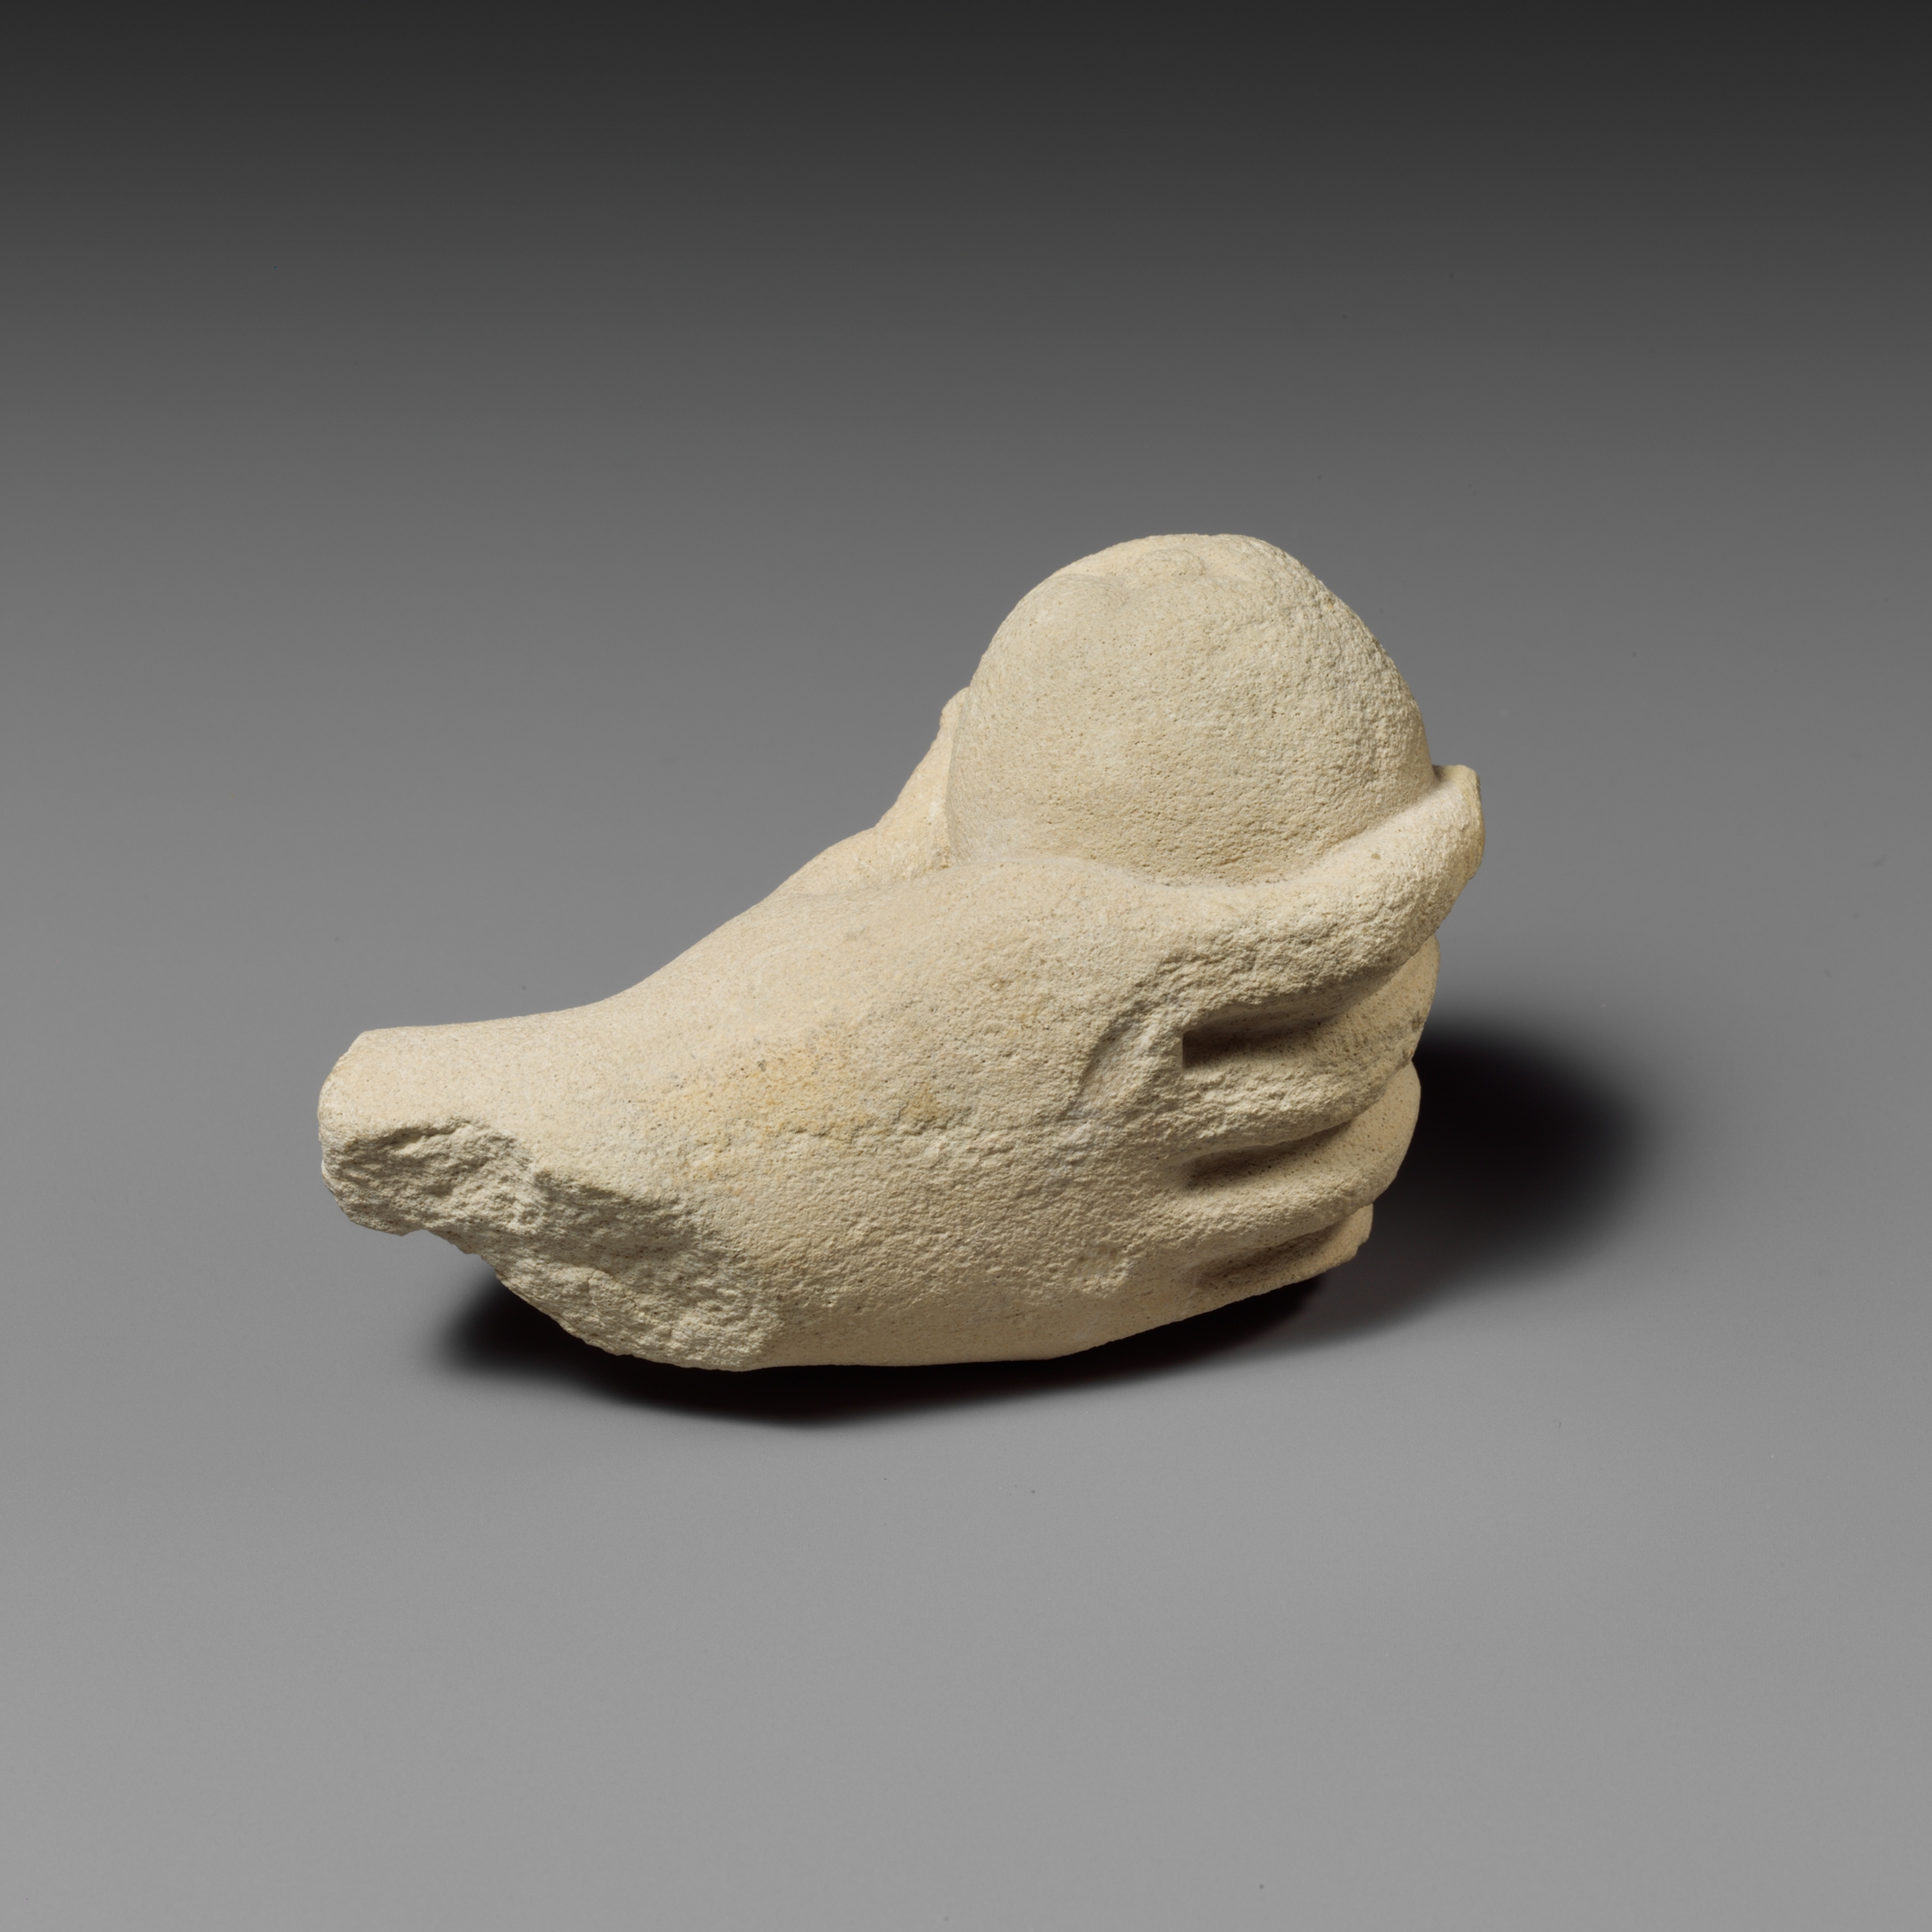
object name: hand, right, holding an apple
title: Limestone hand holding a piece of fruit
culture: cypriot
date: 3900 BCE-100 CE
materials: limestone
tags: fruit,hands